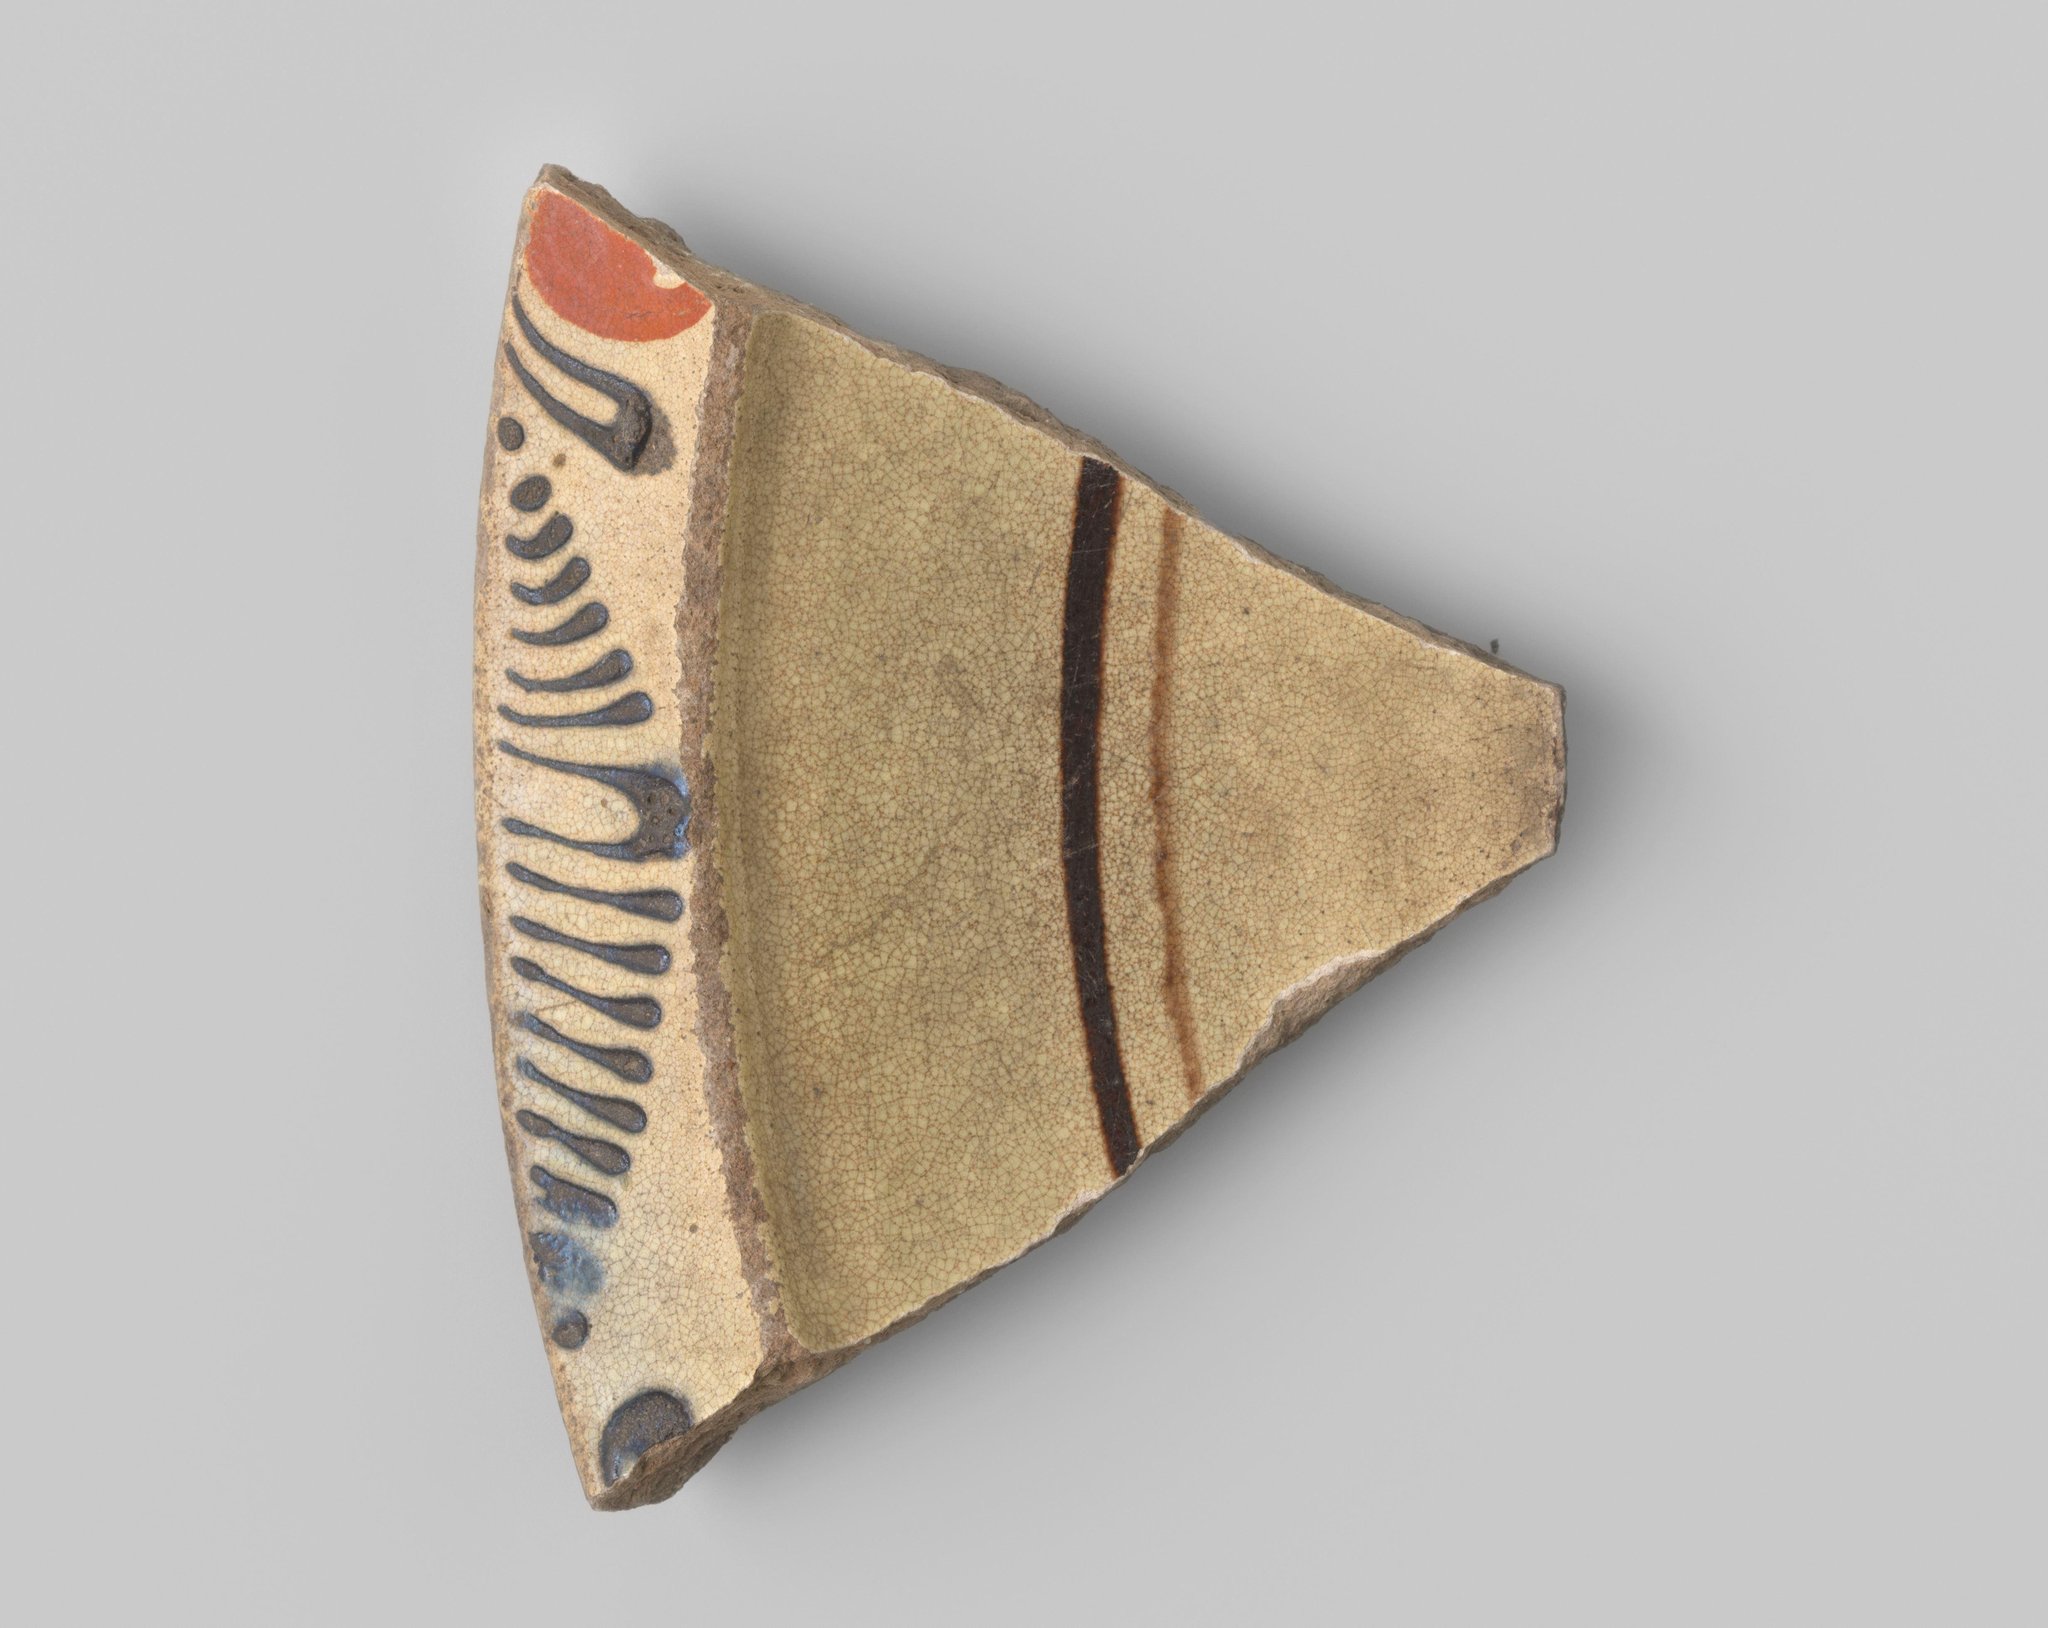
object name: sherd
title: Scherf van witbakkend aardewerk,aan de bovenzijde voorzien van een beschildering van strepen in blauw, bruin en oranje op een gelige ondergrond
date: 1500-1899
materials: earthenware, glaze